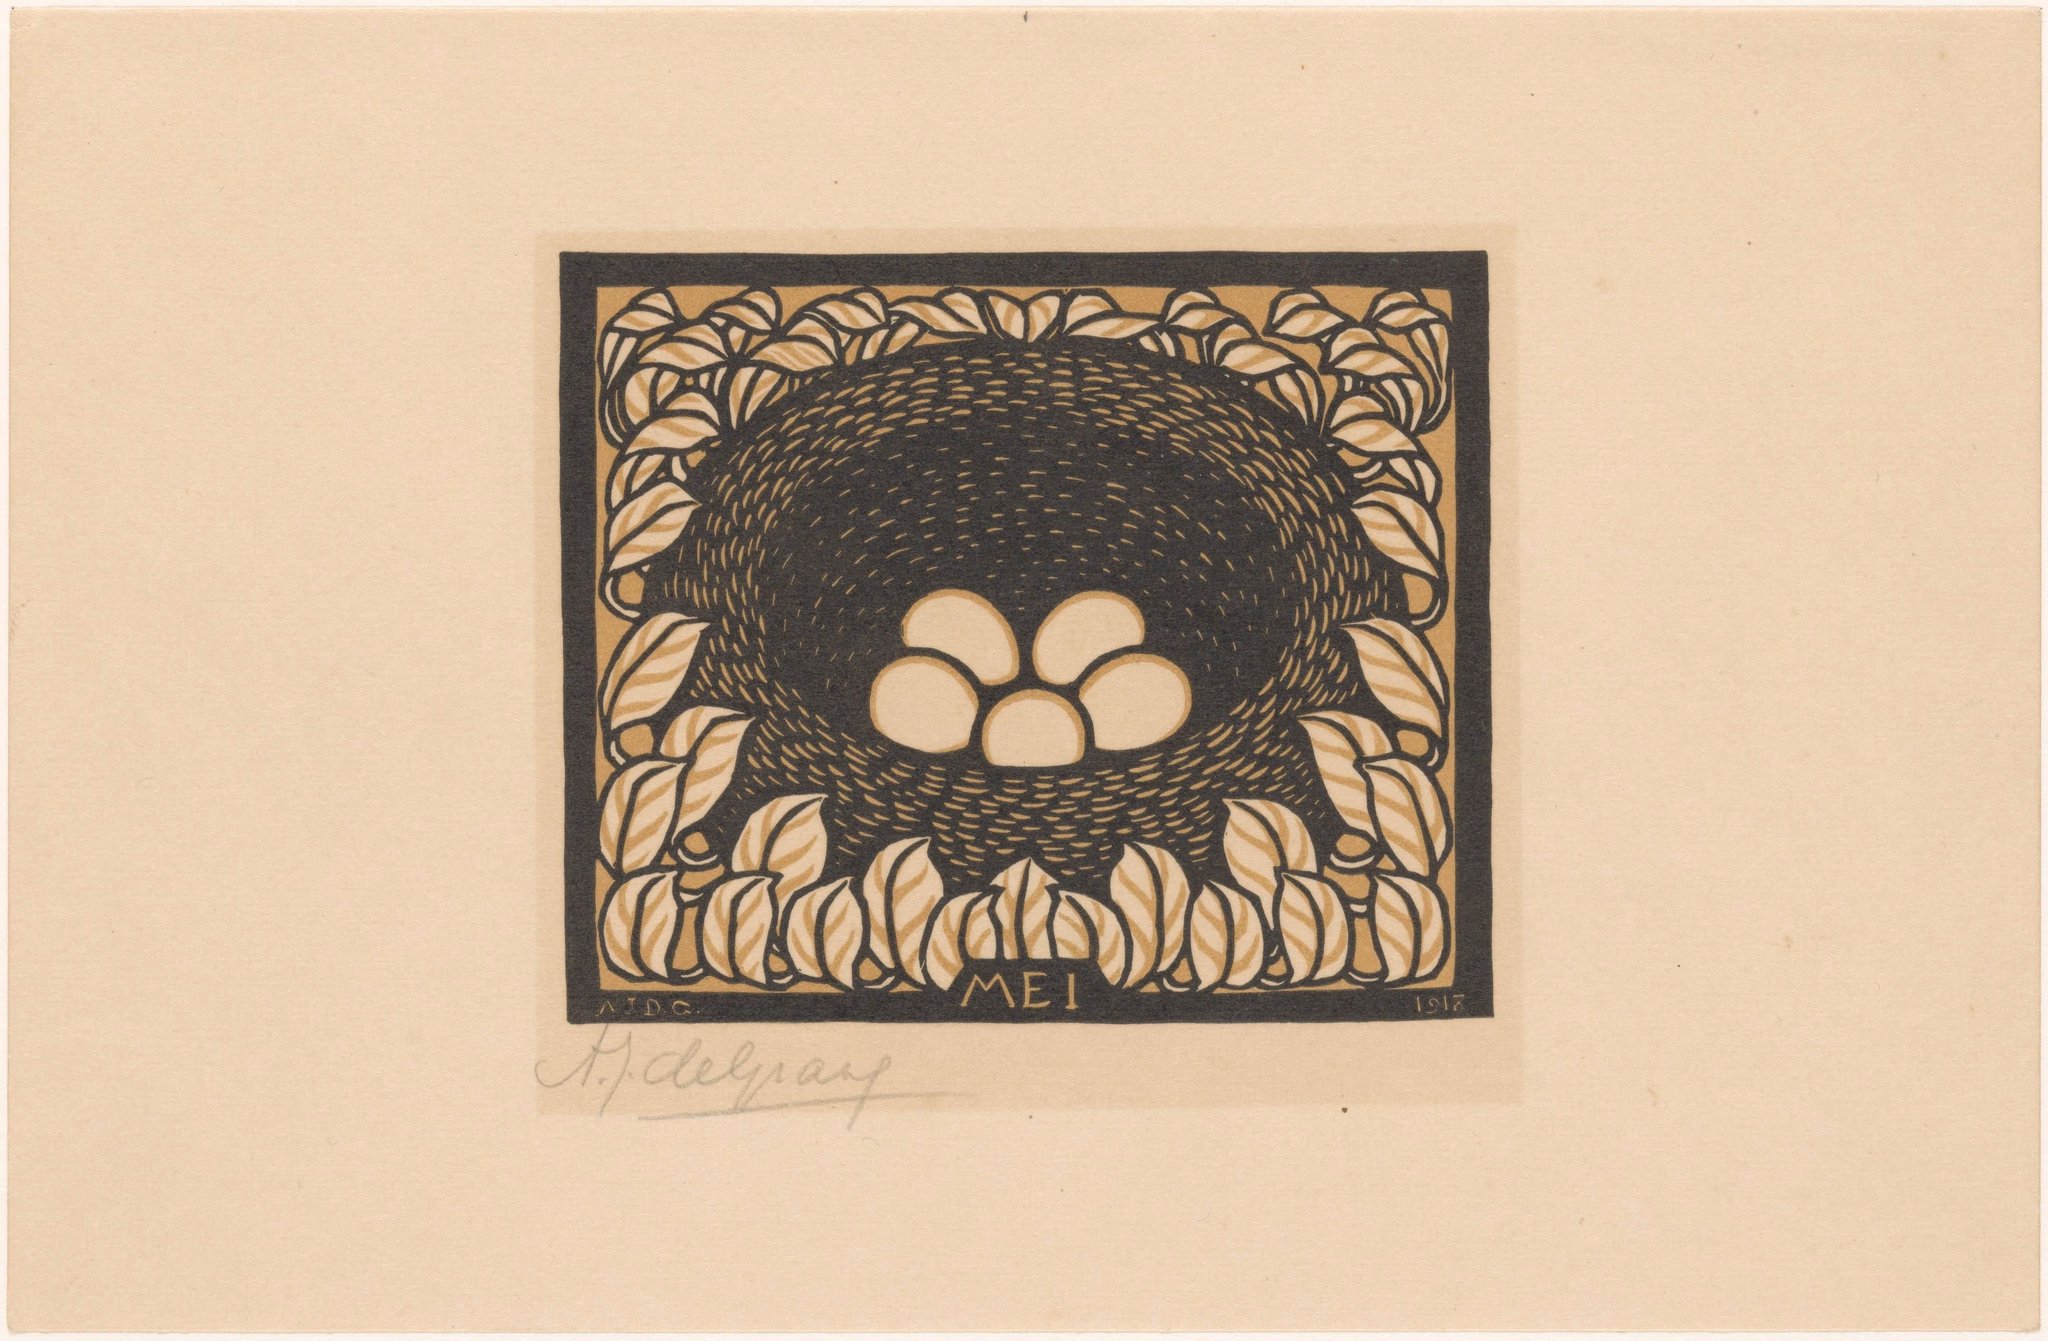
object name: print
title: Mei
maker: julie de graag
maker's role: draughtsman, print maker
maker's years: 1877-1924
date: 1918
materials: paper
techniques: woodcut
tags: birds (+ nest, den, burrow), may; 'maggio' (ripa)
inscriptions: collector's mark: Lugt 2228